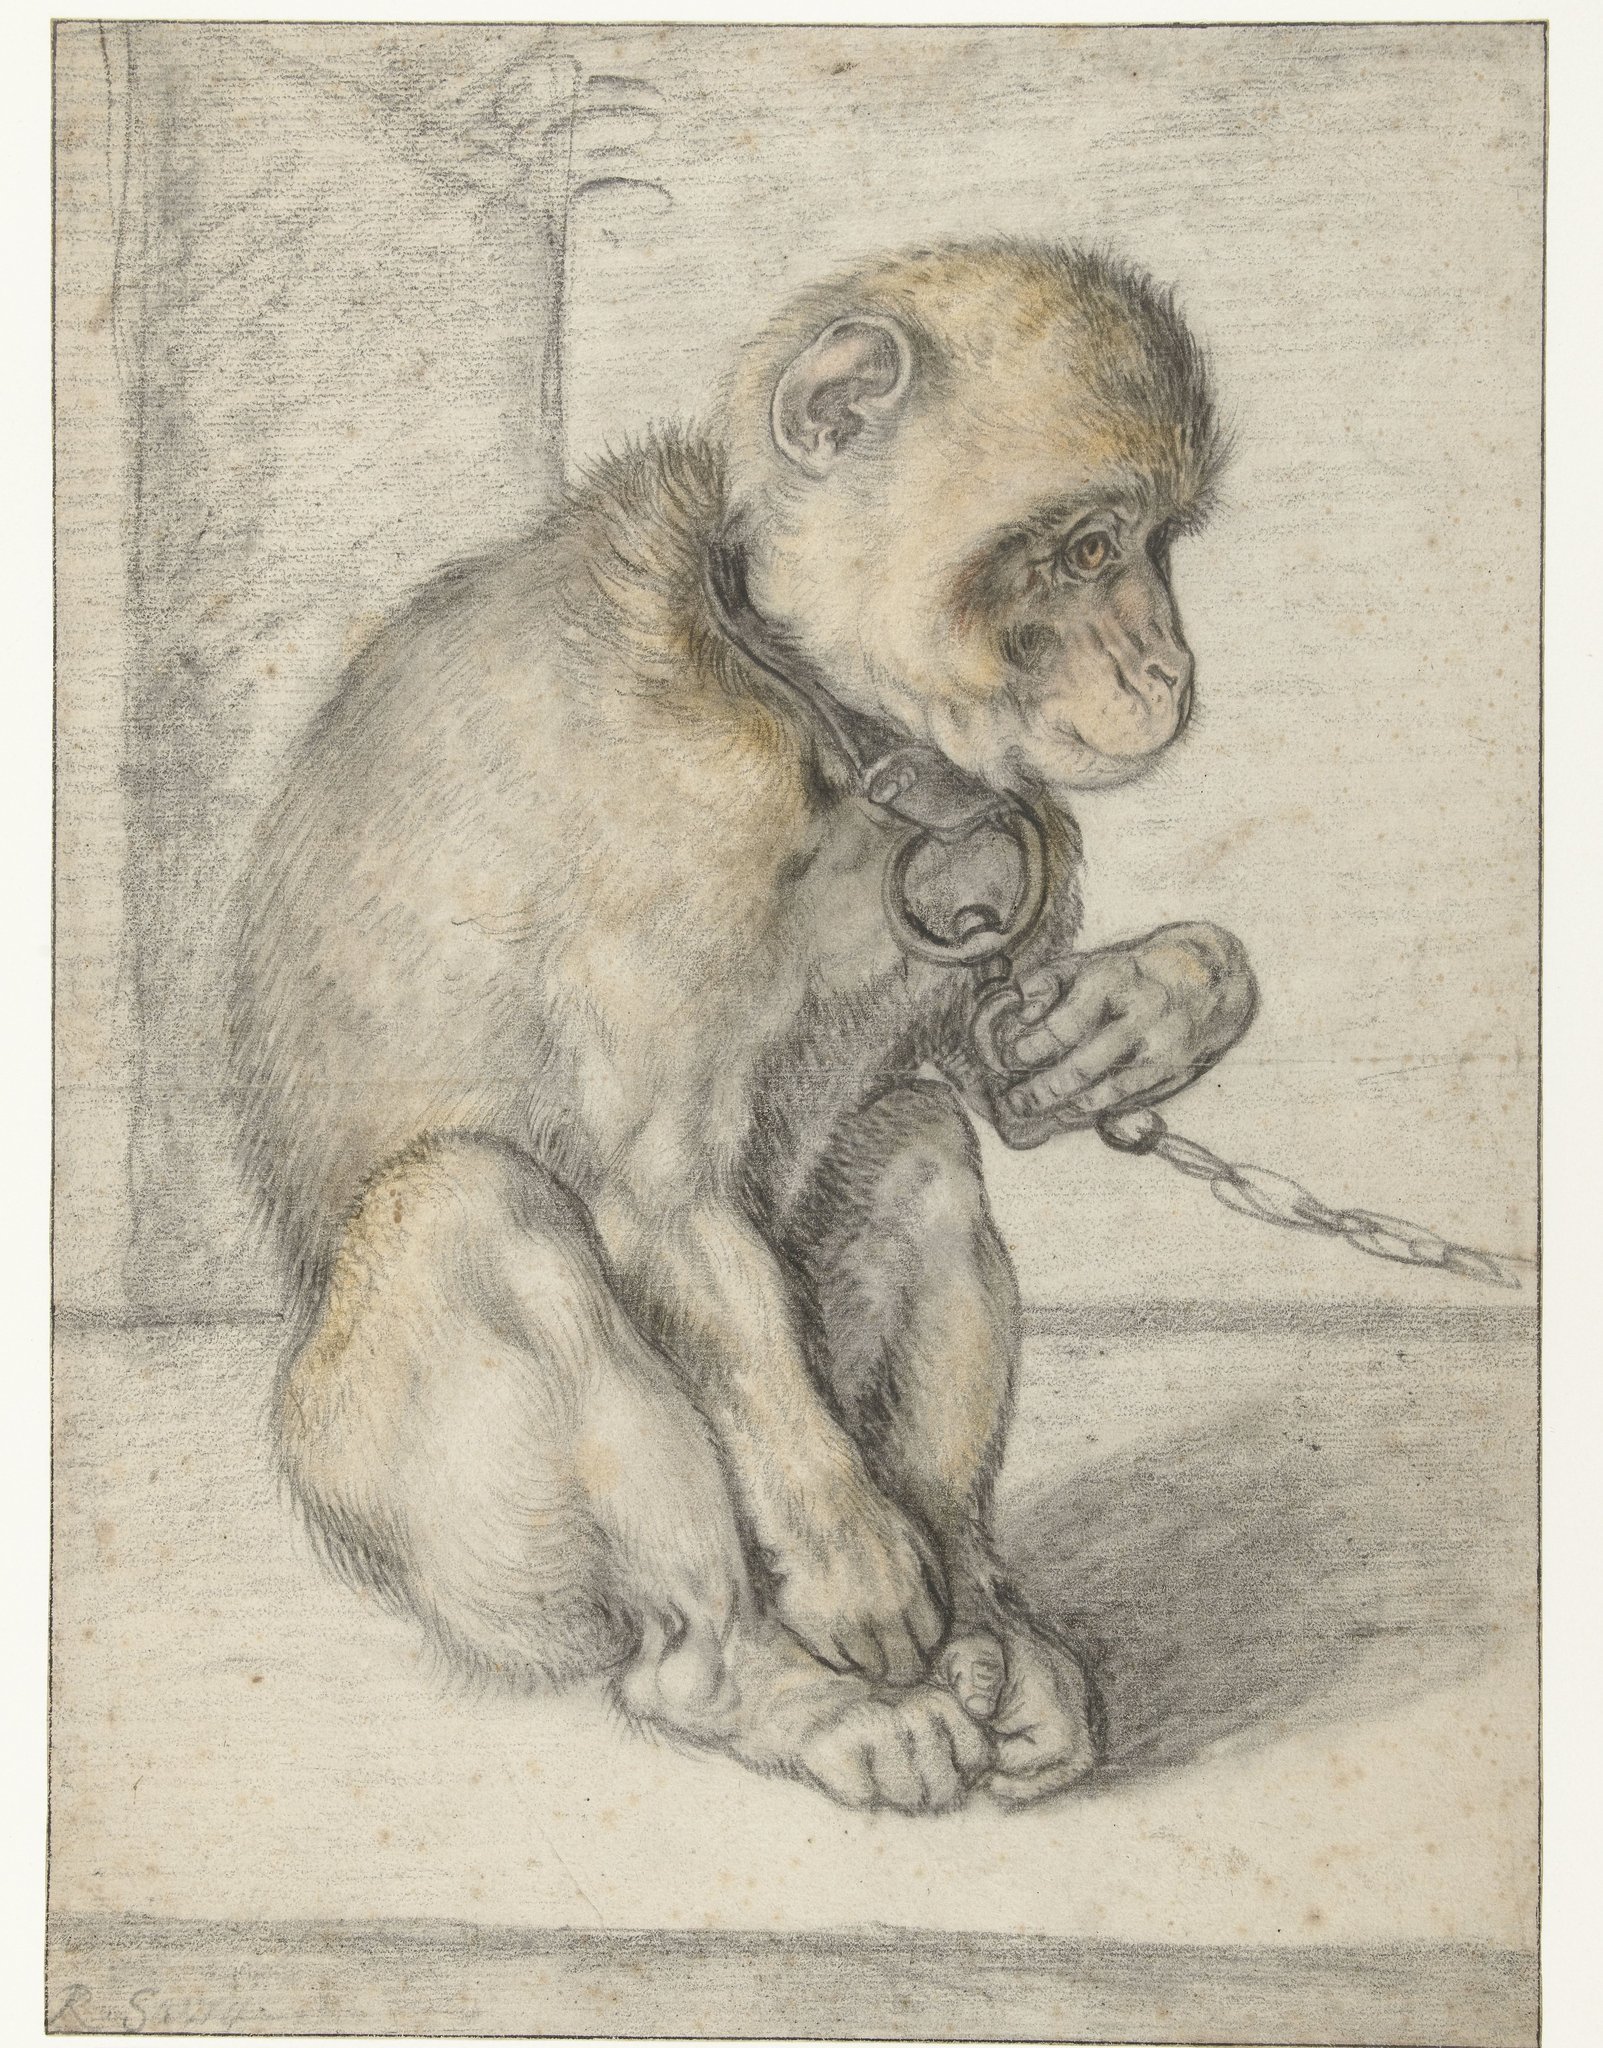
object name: drawing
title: A Seated Monkey on a Chain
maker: hendrick goltzius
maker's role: draughtsman, painter, print maker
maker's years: 1558-1617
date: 1592-1602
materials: chalk, paper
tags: monkeys, apes, animals tied up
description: With masterly strokes and hatching, Hendrick Goltzius drew this Asian rhesus monkey, recognizable by its pinkish face, framed by fur. He devoted a great deal of attention to the faithful rendering of the fur, cleverly using the white of the paper to create subtle contrasts of light and dark. A fettered monkey had a special meaning, alluding to sinful man who is shackled to the earth through his lust for wealth.